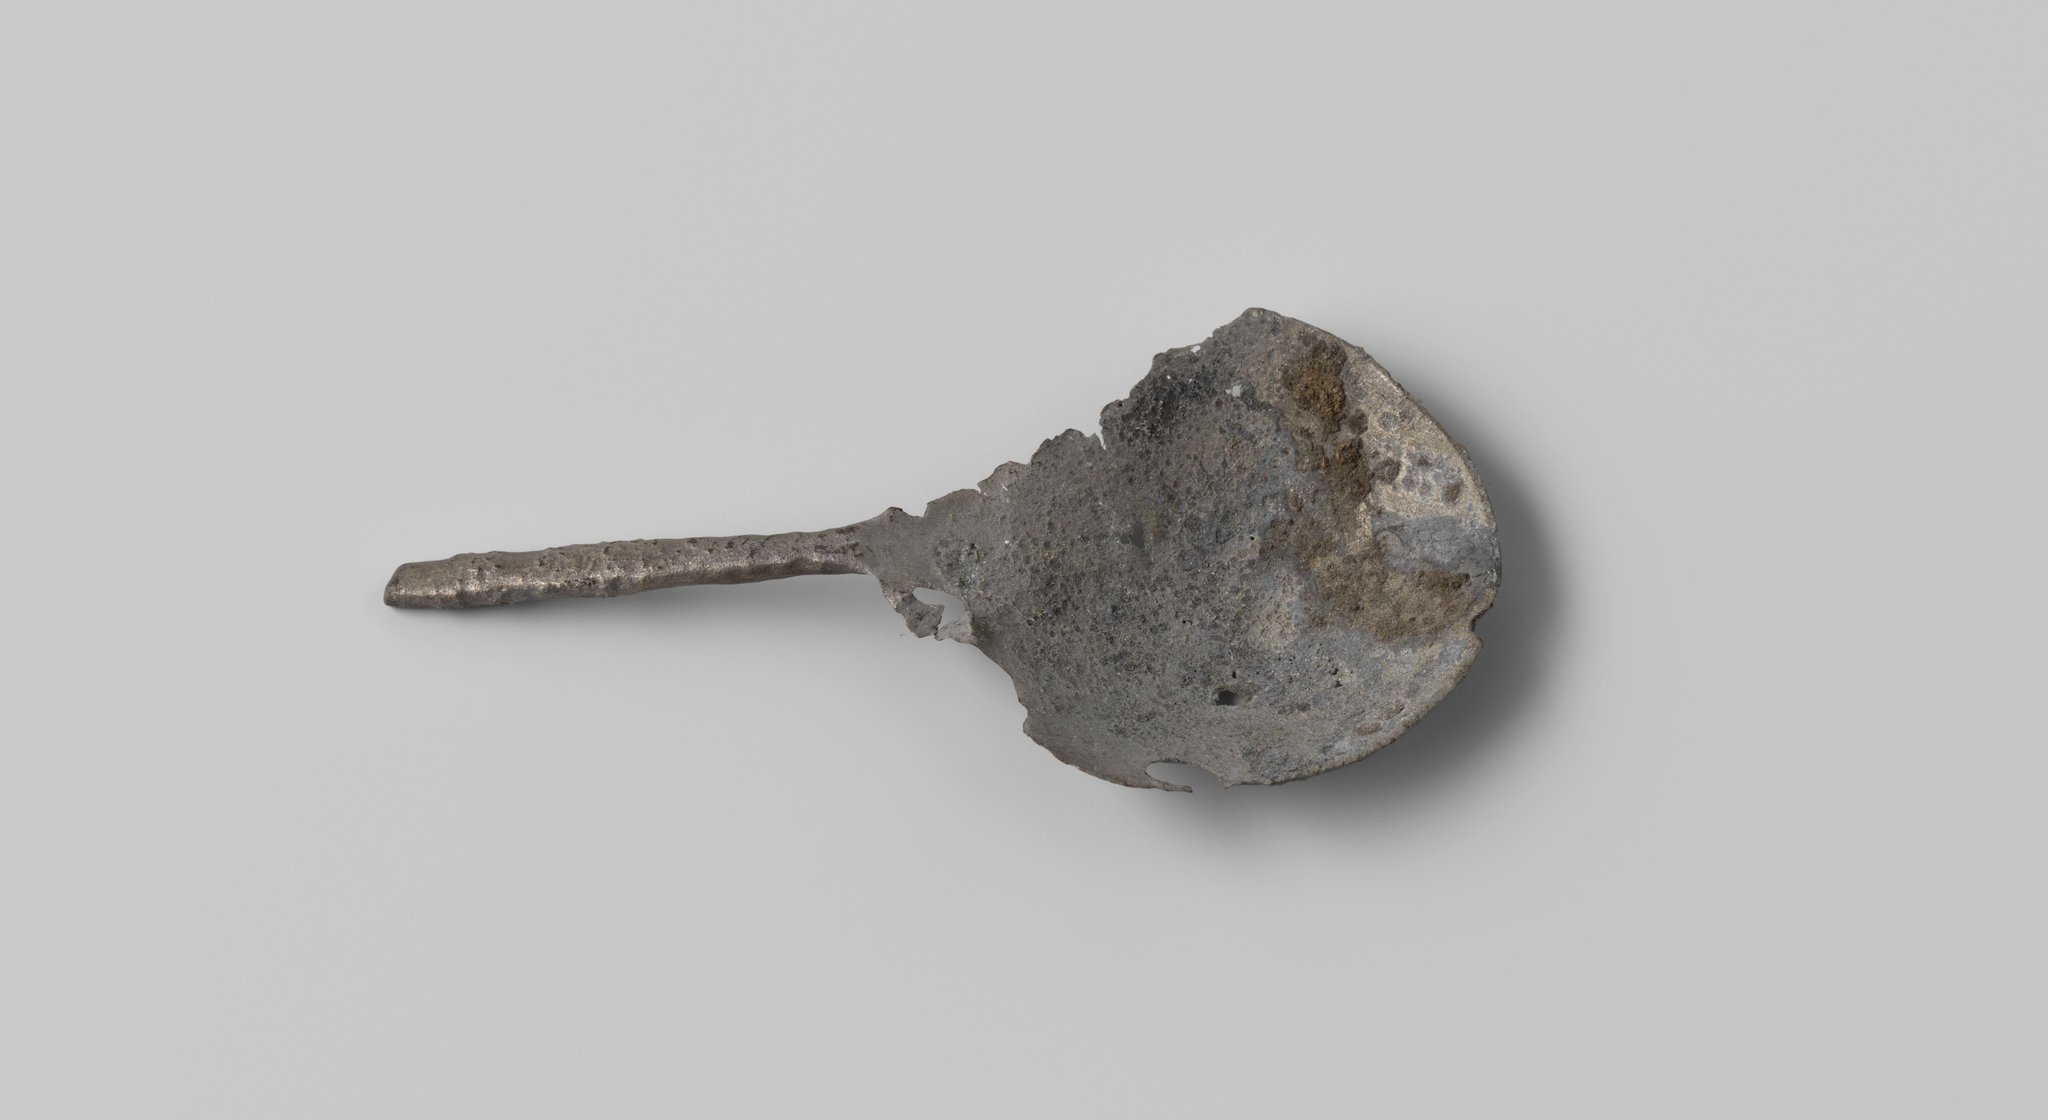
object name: spoon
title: Lepel uit het wrak van de Oost-Indiëvaarder Princesse Maria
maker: Anonymous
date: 1670-1686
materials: tin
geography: netherlands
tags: princesse maria (schip), verenigde oostindische compagnie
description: Tinnen beschadigde lepel, massive ronde steel en ronde lepel.